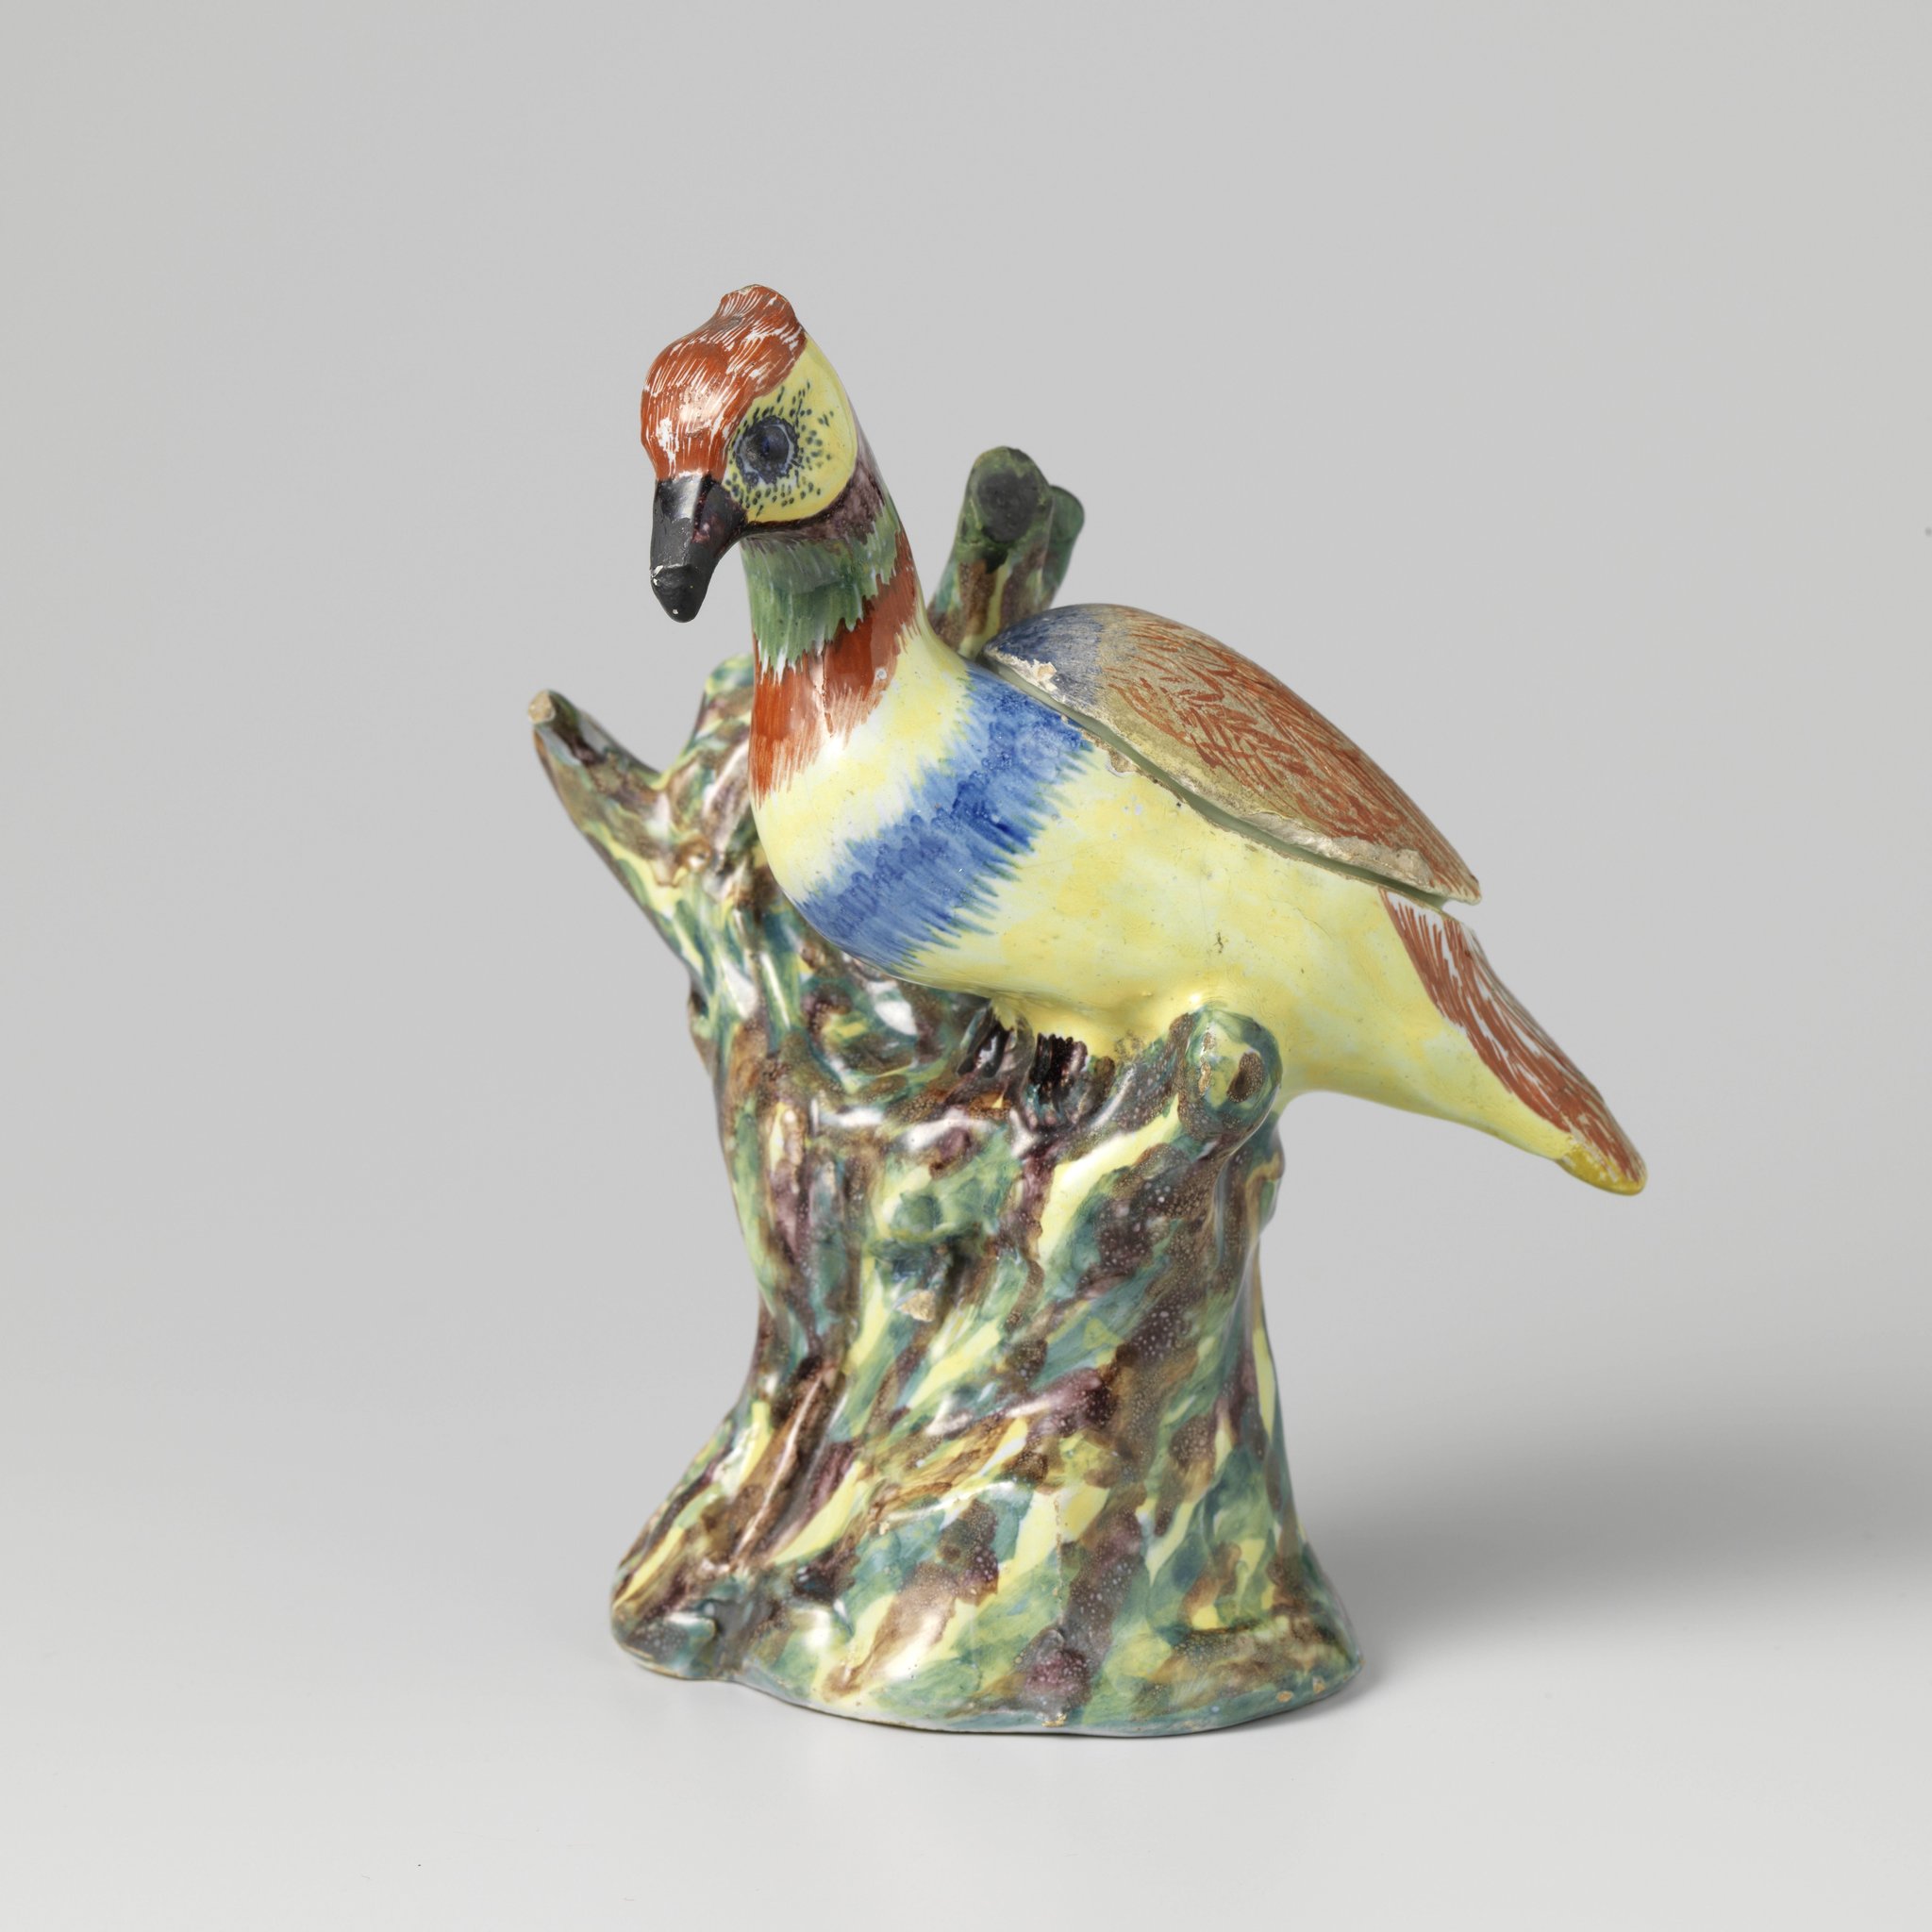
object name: decoratief object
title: Vogel op boomstam van faience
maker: Anonymous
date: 1750-1780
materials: faience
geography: delft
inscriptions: mark: ‘14’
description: Vogel op boomstam van faience. Veelkleurig beschilderd.